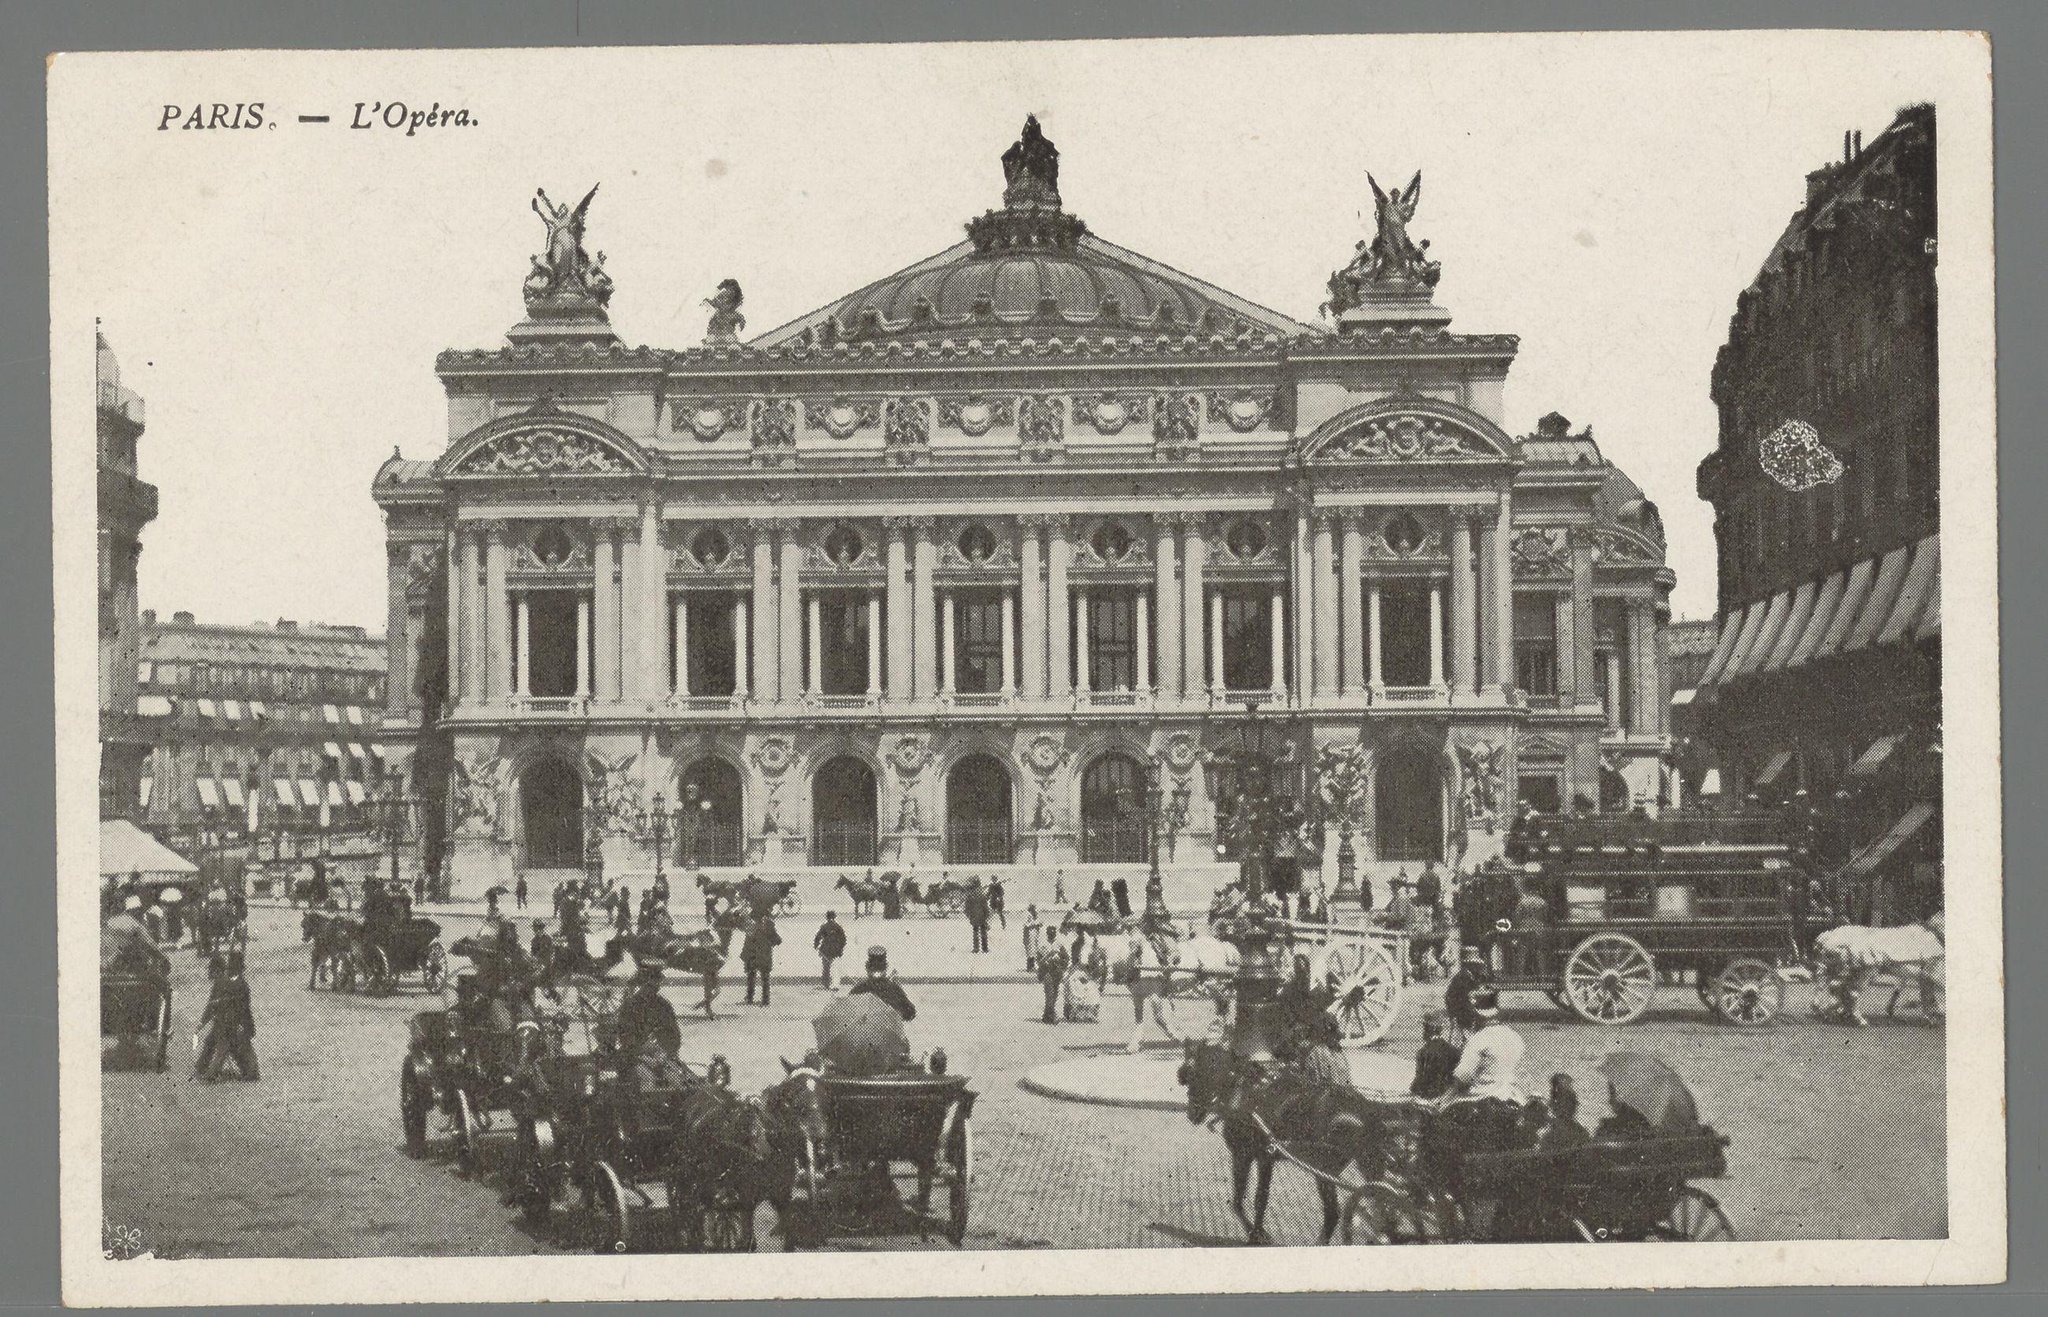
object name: photomechanical print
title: Paris. L'Opéra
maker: Anonymous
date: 1904-1906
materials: cardboard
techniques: autotype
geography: paris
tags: four-wheeled, animal-drawn vehicle, e.g.: cab, carriage, coach, square, place, circus, etc. (+ city(-scape) with figures, staffage), opera house